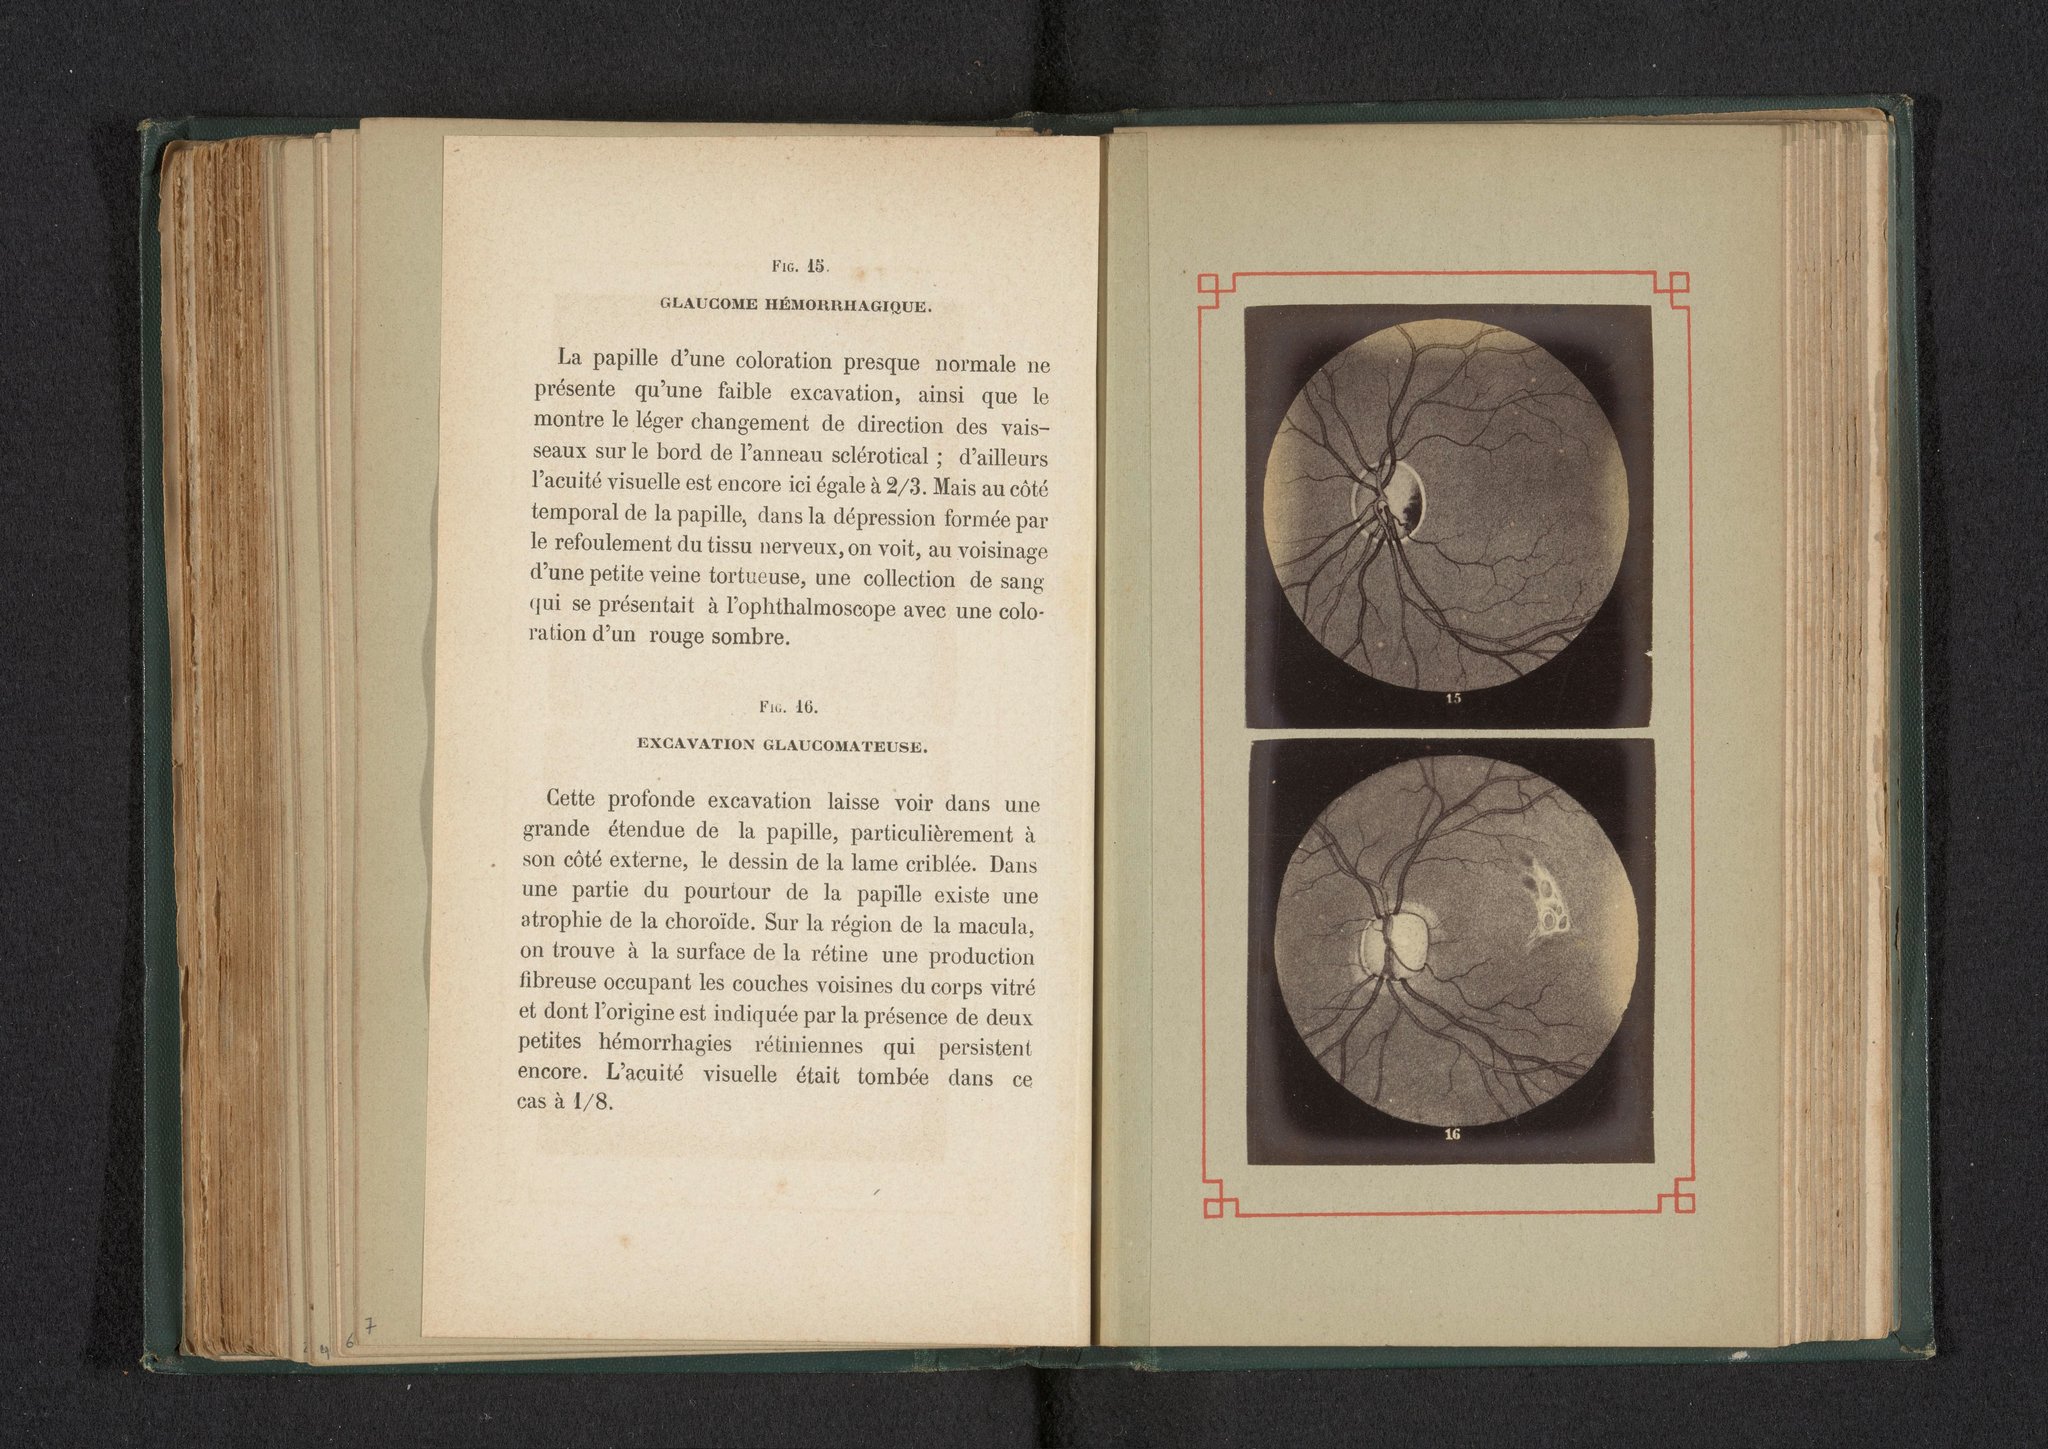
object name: photograph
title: Fotoreproductie van twee anatomische tekeningen van een bloeding en een vervorming van een oog door glaucoom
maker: Anonymous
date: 1871-1881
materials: photographic support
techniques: albumen print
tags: anatomy (non-medical), eyes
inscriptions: inscription: ‘Fig. 15. Glaucome hémorrhagique. Fig. 16. Excavation glaucomateuse.’